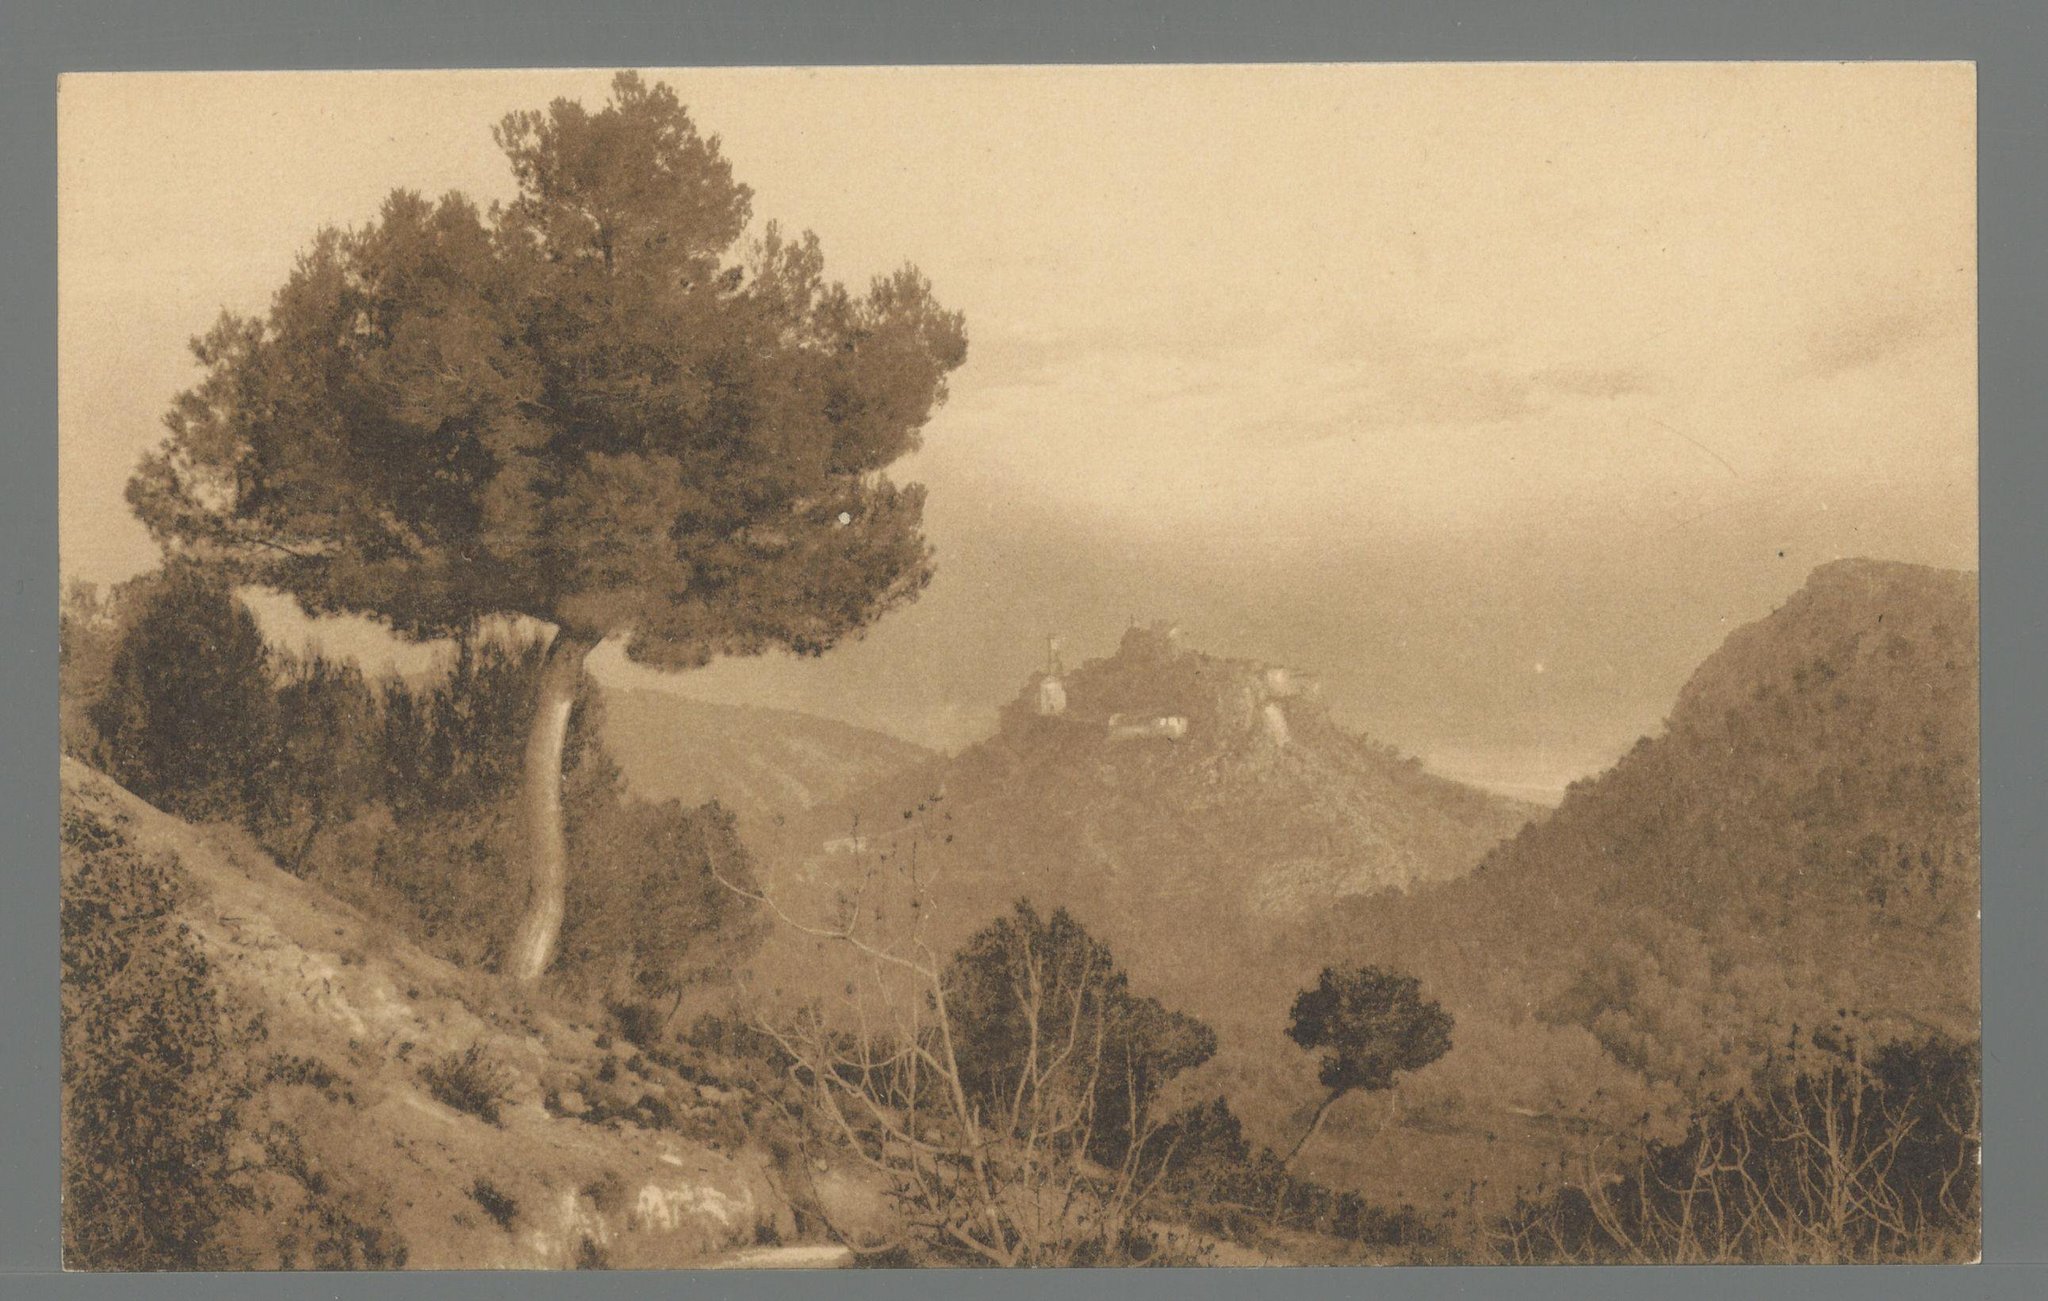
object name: ansichtkaart, prentbriefkaart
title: Eze. Vue prise de la Grande Corniche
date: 1904-1906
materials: cardboard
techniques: photograph, writing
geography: paris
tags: city-view, and landscape with man-made constructions, landscapes with waters, waterscapes, seascapes (in the temperate zone)